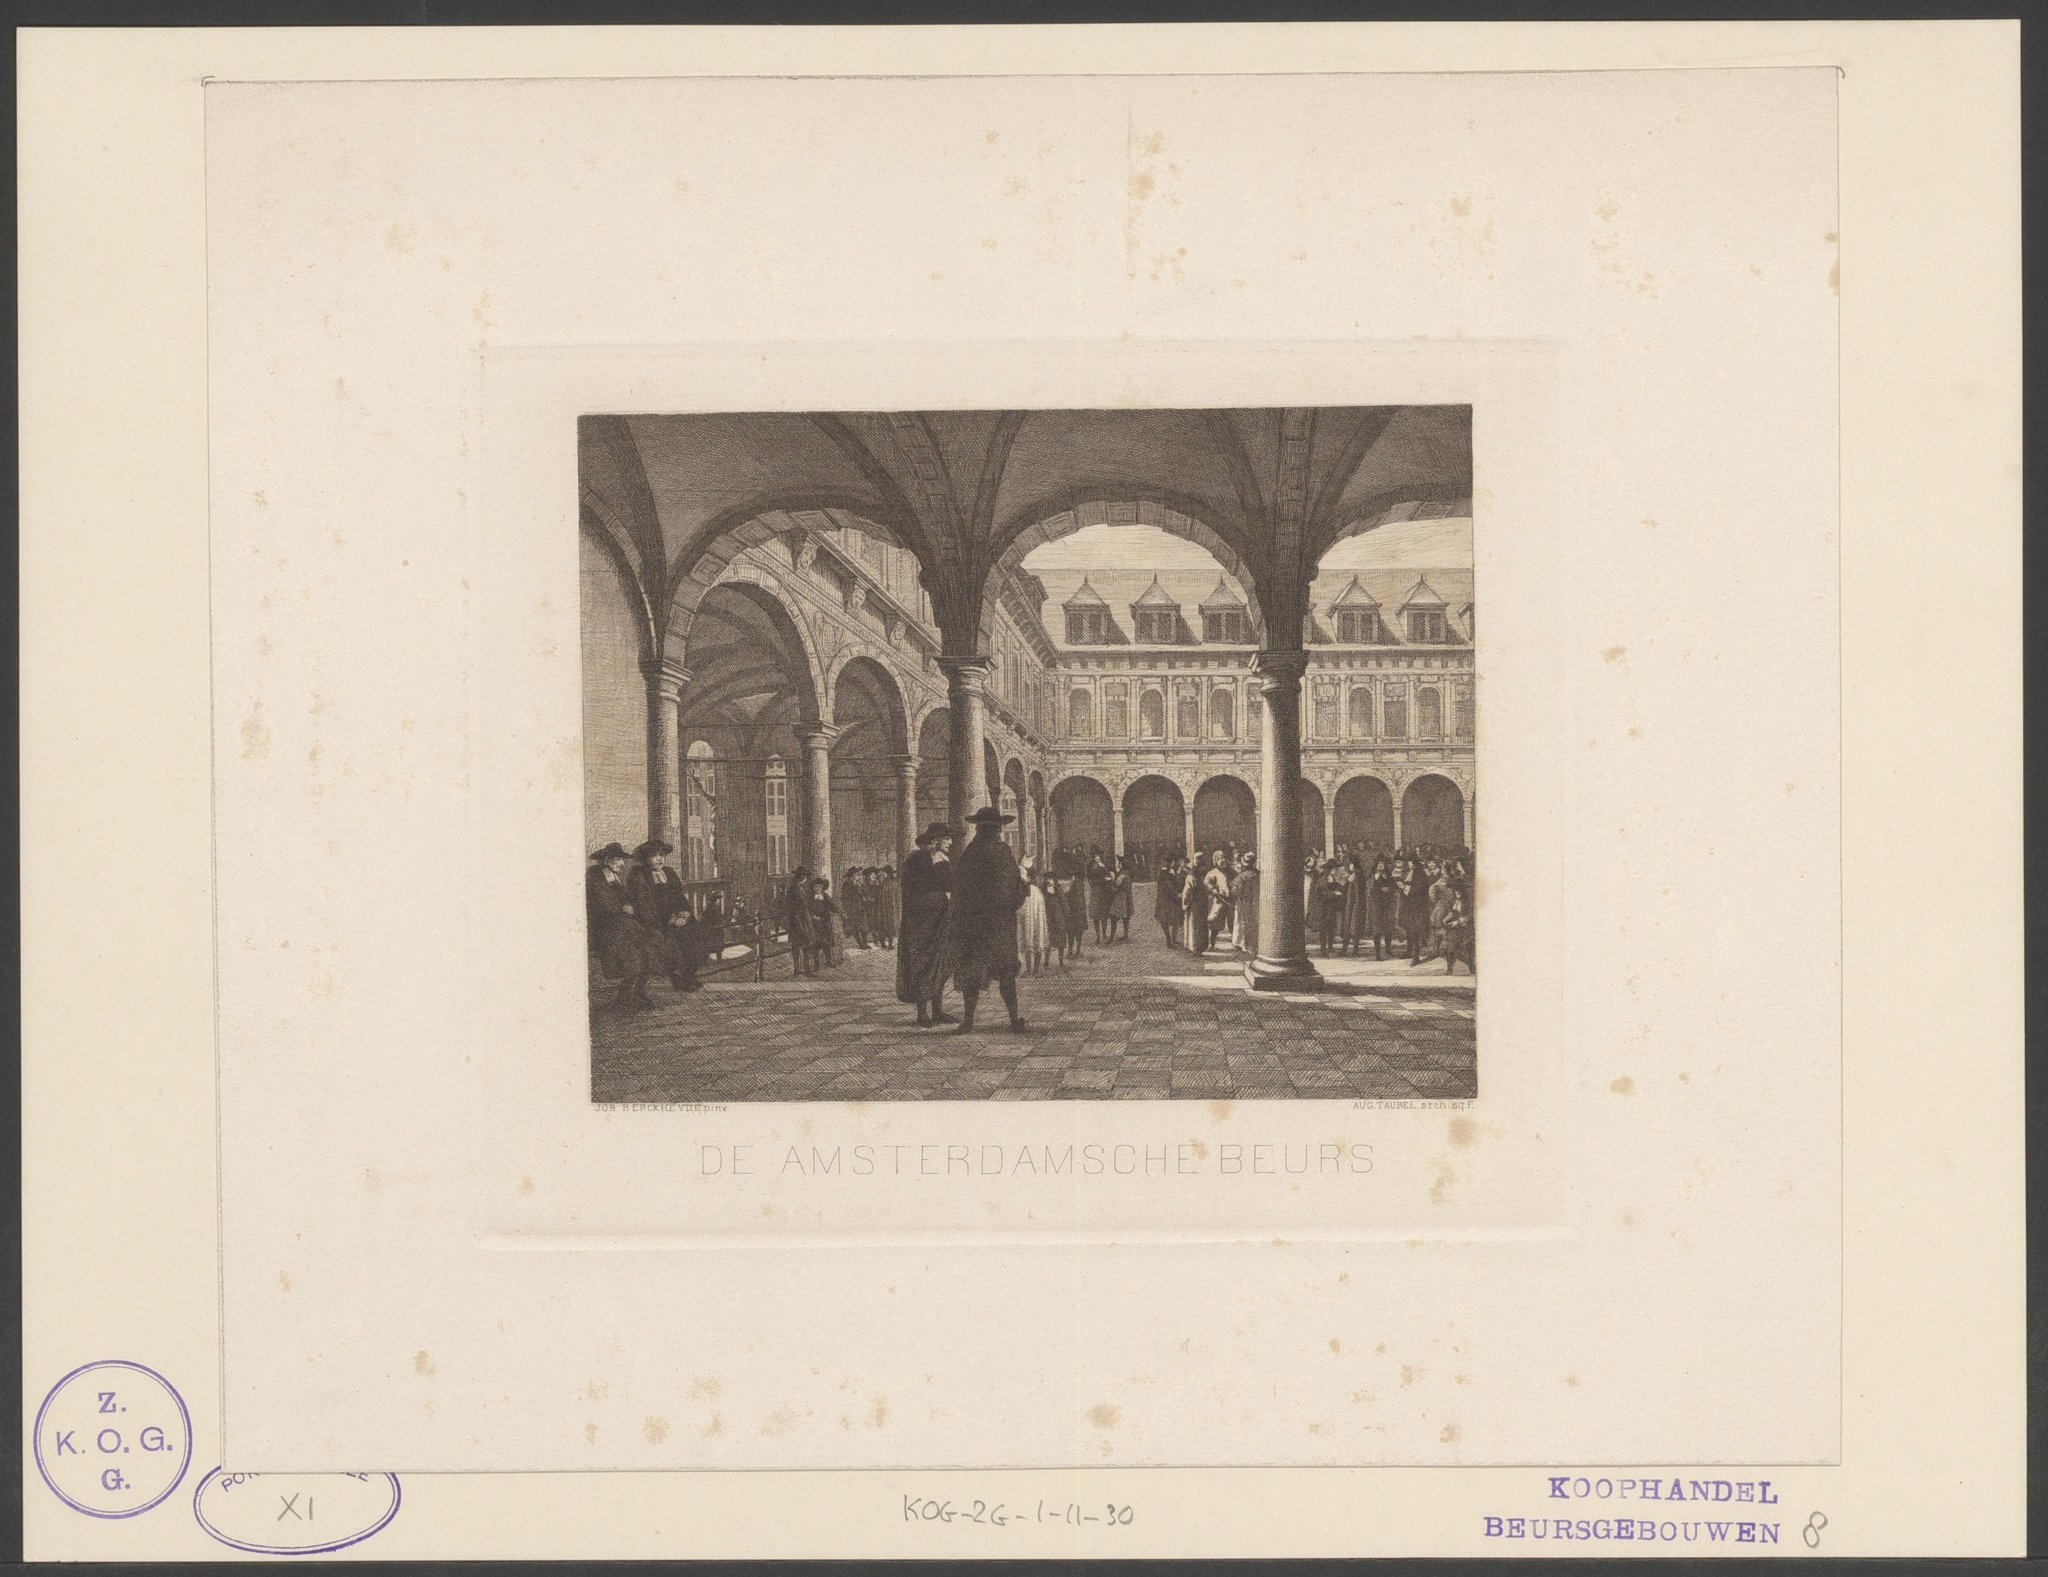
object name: print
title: Gezicht op de binnenplaats van de Beurs van Hendrick de Keyser in Amsterdam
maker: augustin taurel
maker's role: draughtsman, print maker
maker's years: 1828-1879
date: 1838-1879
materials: paper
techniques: etching, retroussage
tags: stock exchange, stock-market, street (+ city(-scape) with figures, staffage), amsterdam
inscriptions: stamp, collector's mark: Lugt 1641, stamp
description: Onderwerpsrubrieken binnen de Atlas Zeden en Gewoonten: Handel, nijverheid en verkeer, Koophandel, Beursgebouwen.